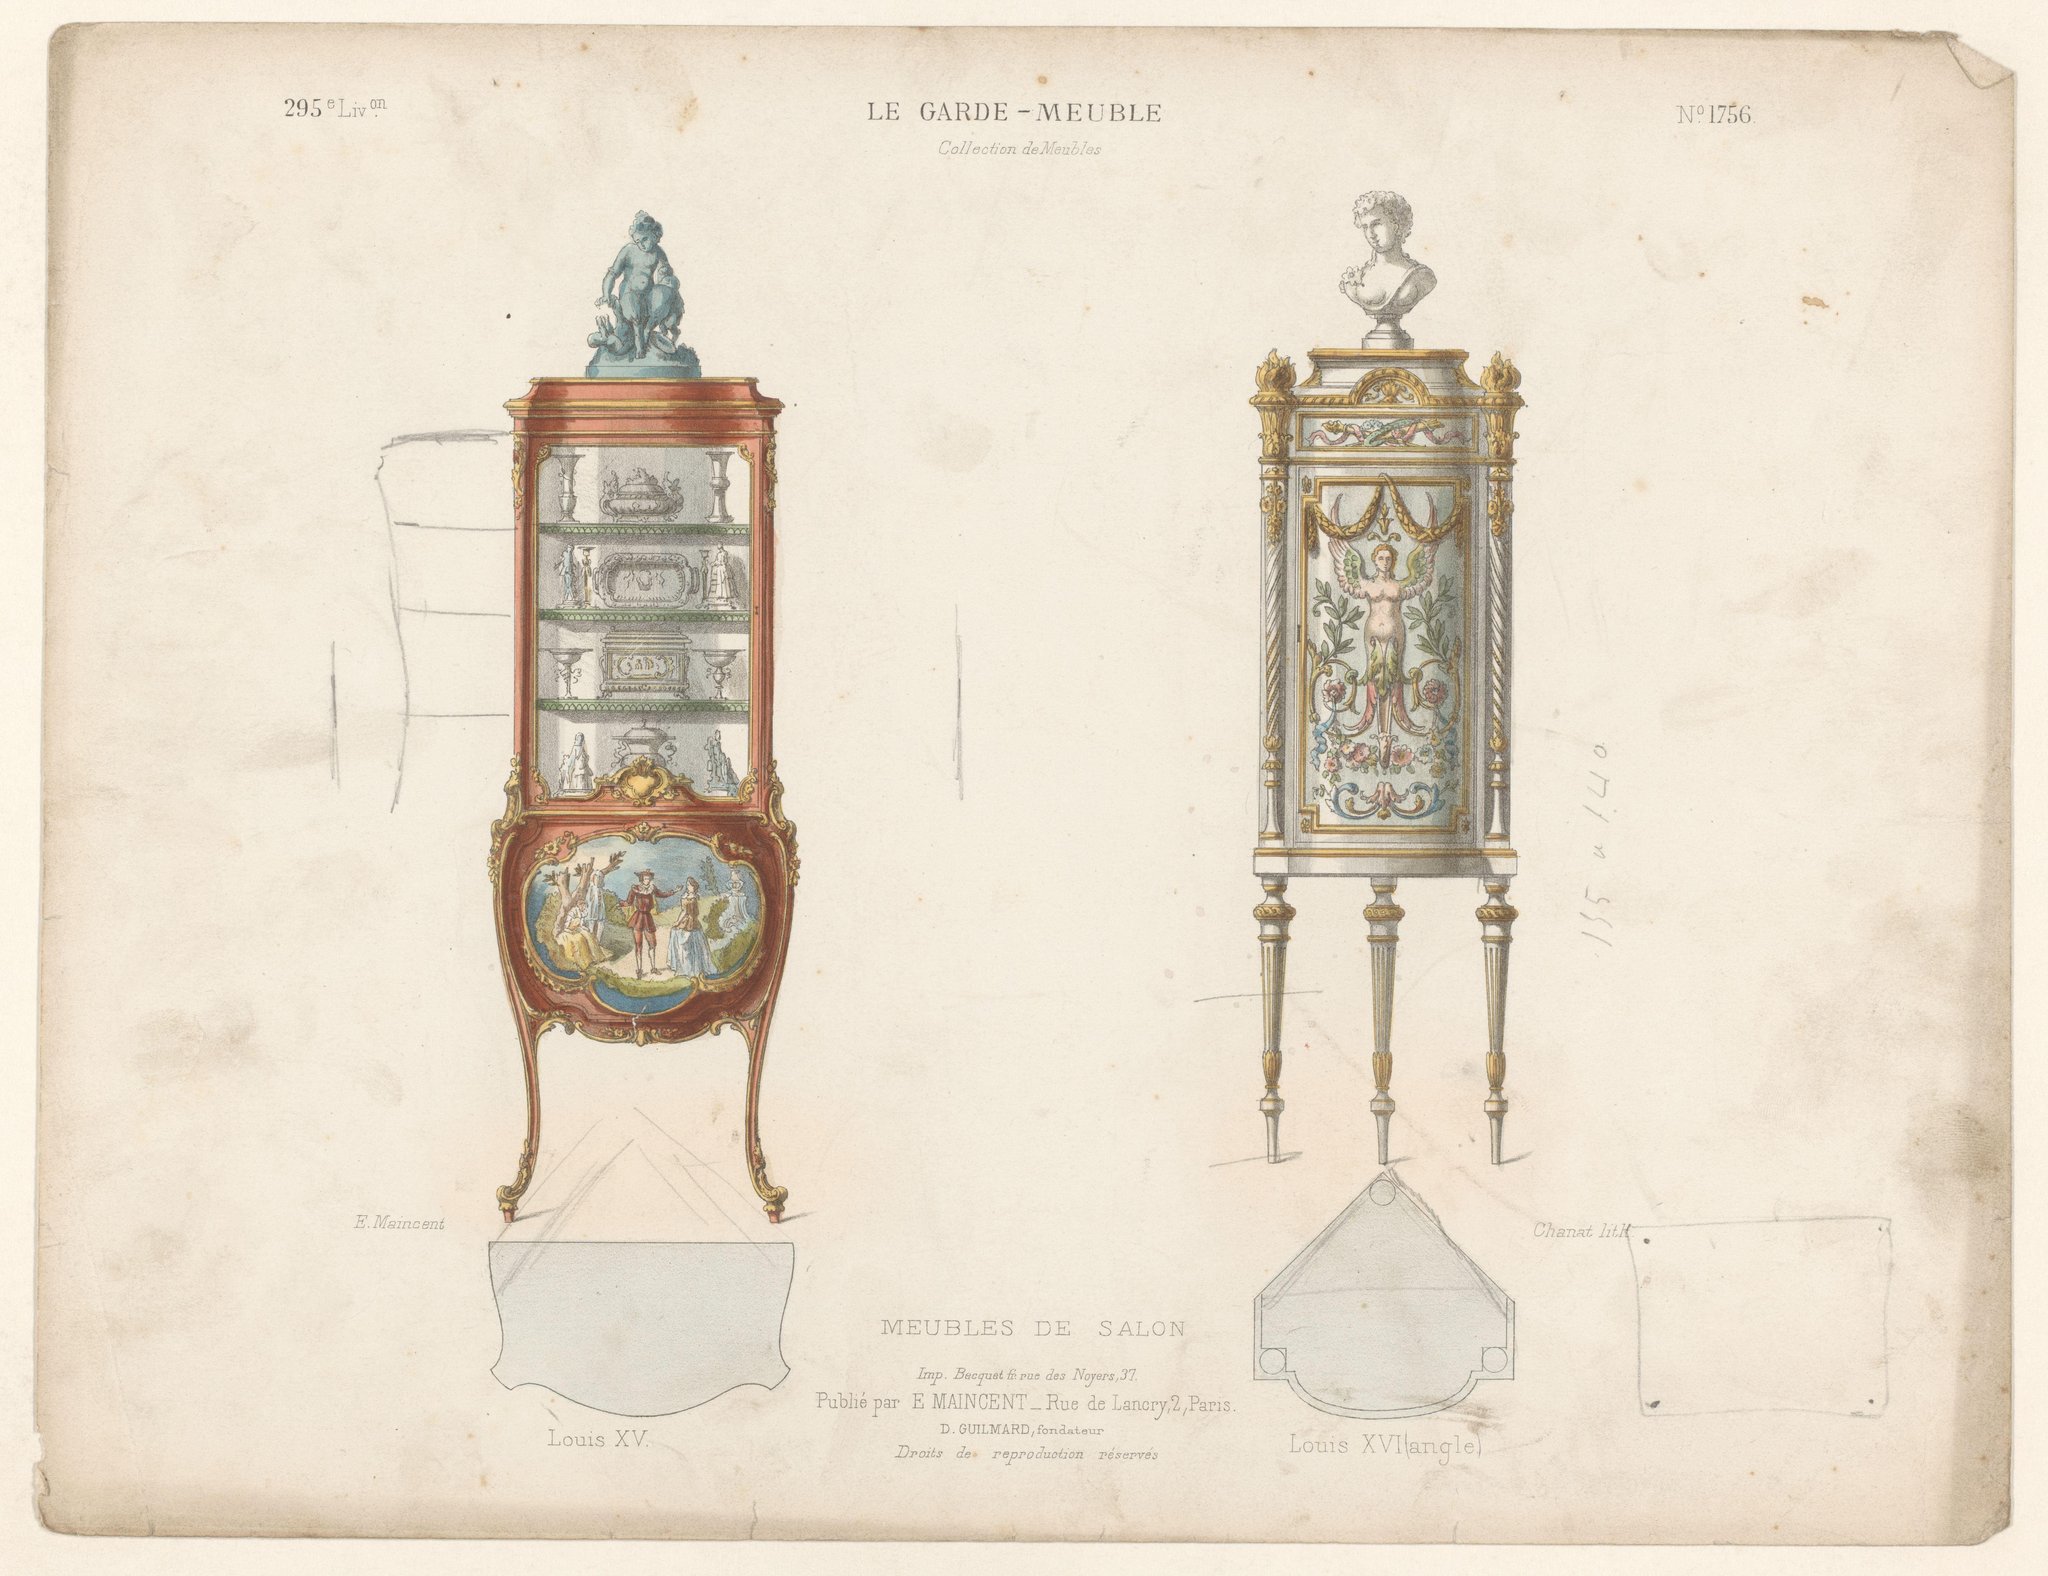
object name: print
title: Twee kasten met beelden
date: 1885-1895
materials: paper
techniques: hand coloring, lithograph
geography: paris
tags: furniture for storage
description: Ieder Livraison in de serie Le Garde-Meuble bevat negen platen: drie 'sièges' (zitmeubels), drie 'meubles' (diverse meubels zoals tafels en kasten) en drie 'tentures' (gordijnen en draperieën).